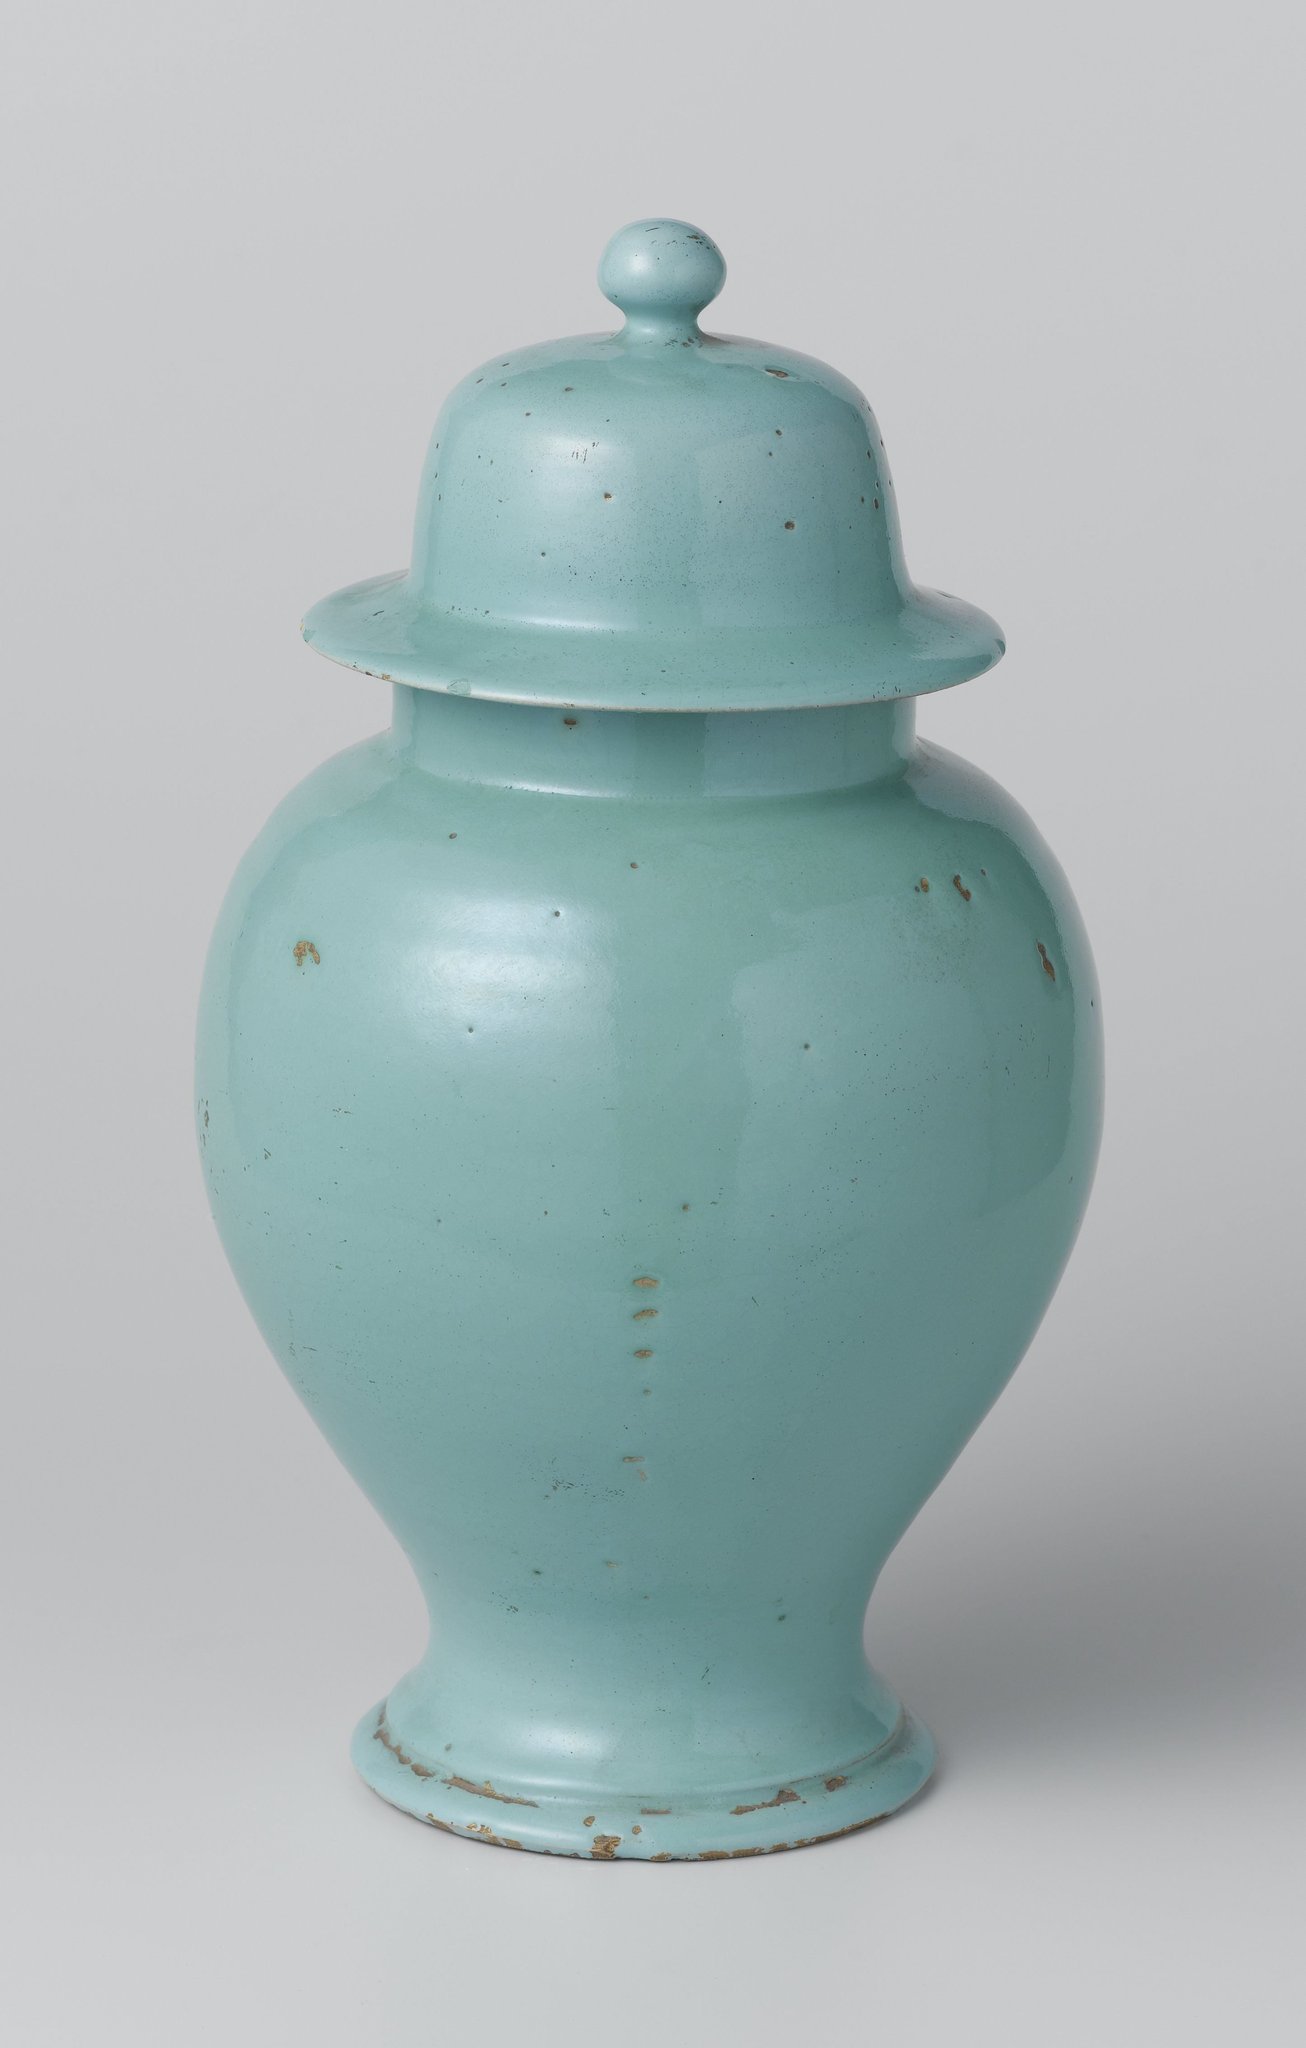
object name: covered jar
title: Dekselpot van faience met blauwgroen fond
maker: Anonymous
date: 1700-1750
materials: earthenware, glaze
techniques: painted, polychromy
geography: delft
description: Pot van veelkleurig beschilderde faience op een blauwgroene fond, met deksel. De pot is onderdeel van een stel. Bij de pot horen twee identieke potten en twee bekers.